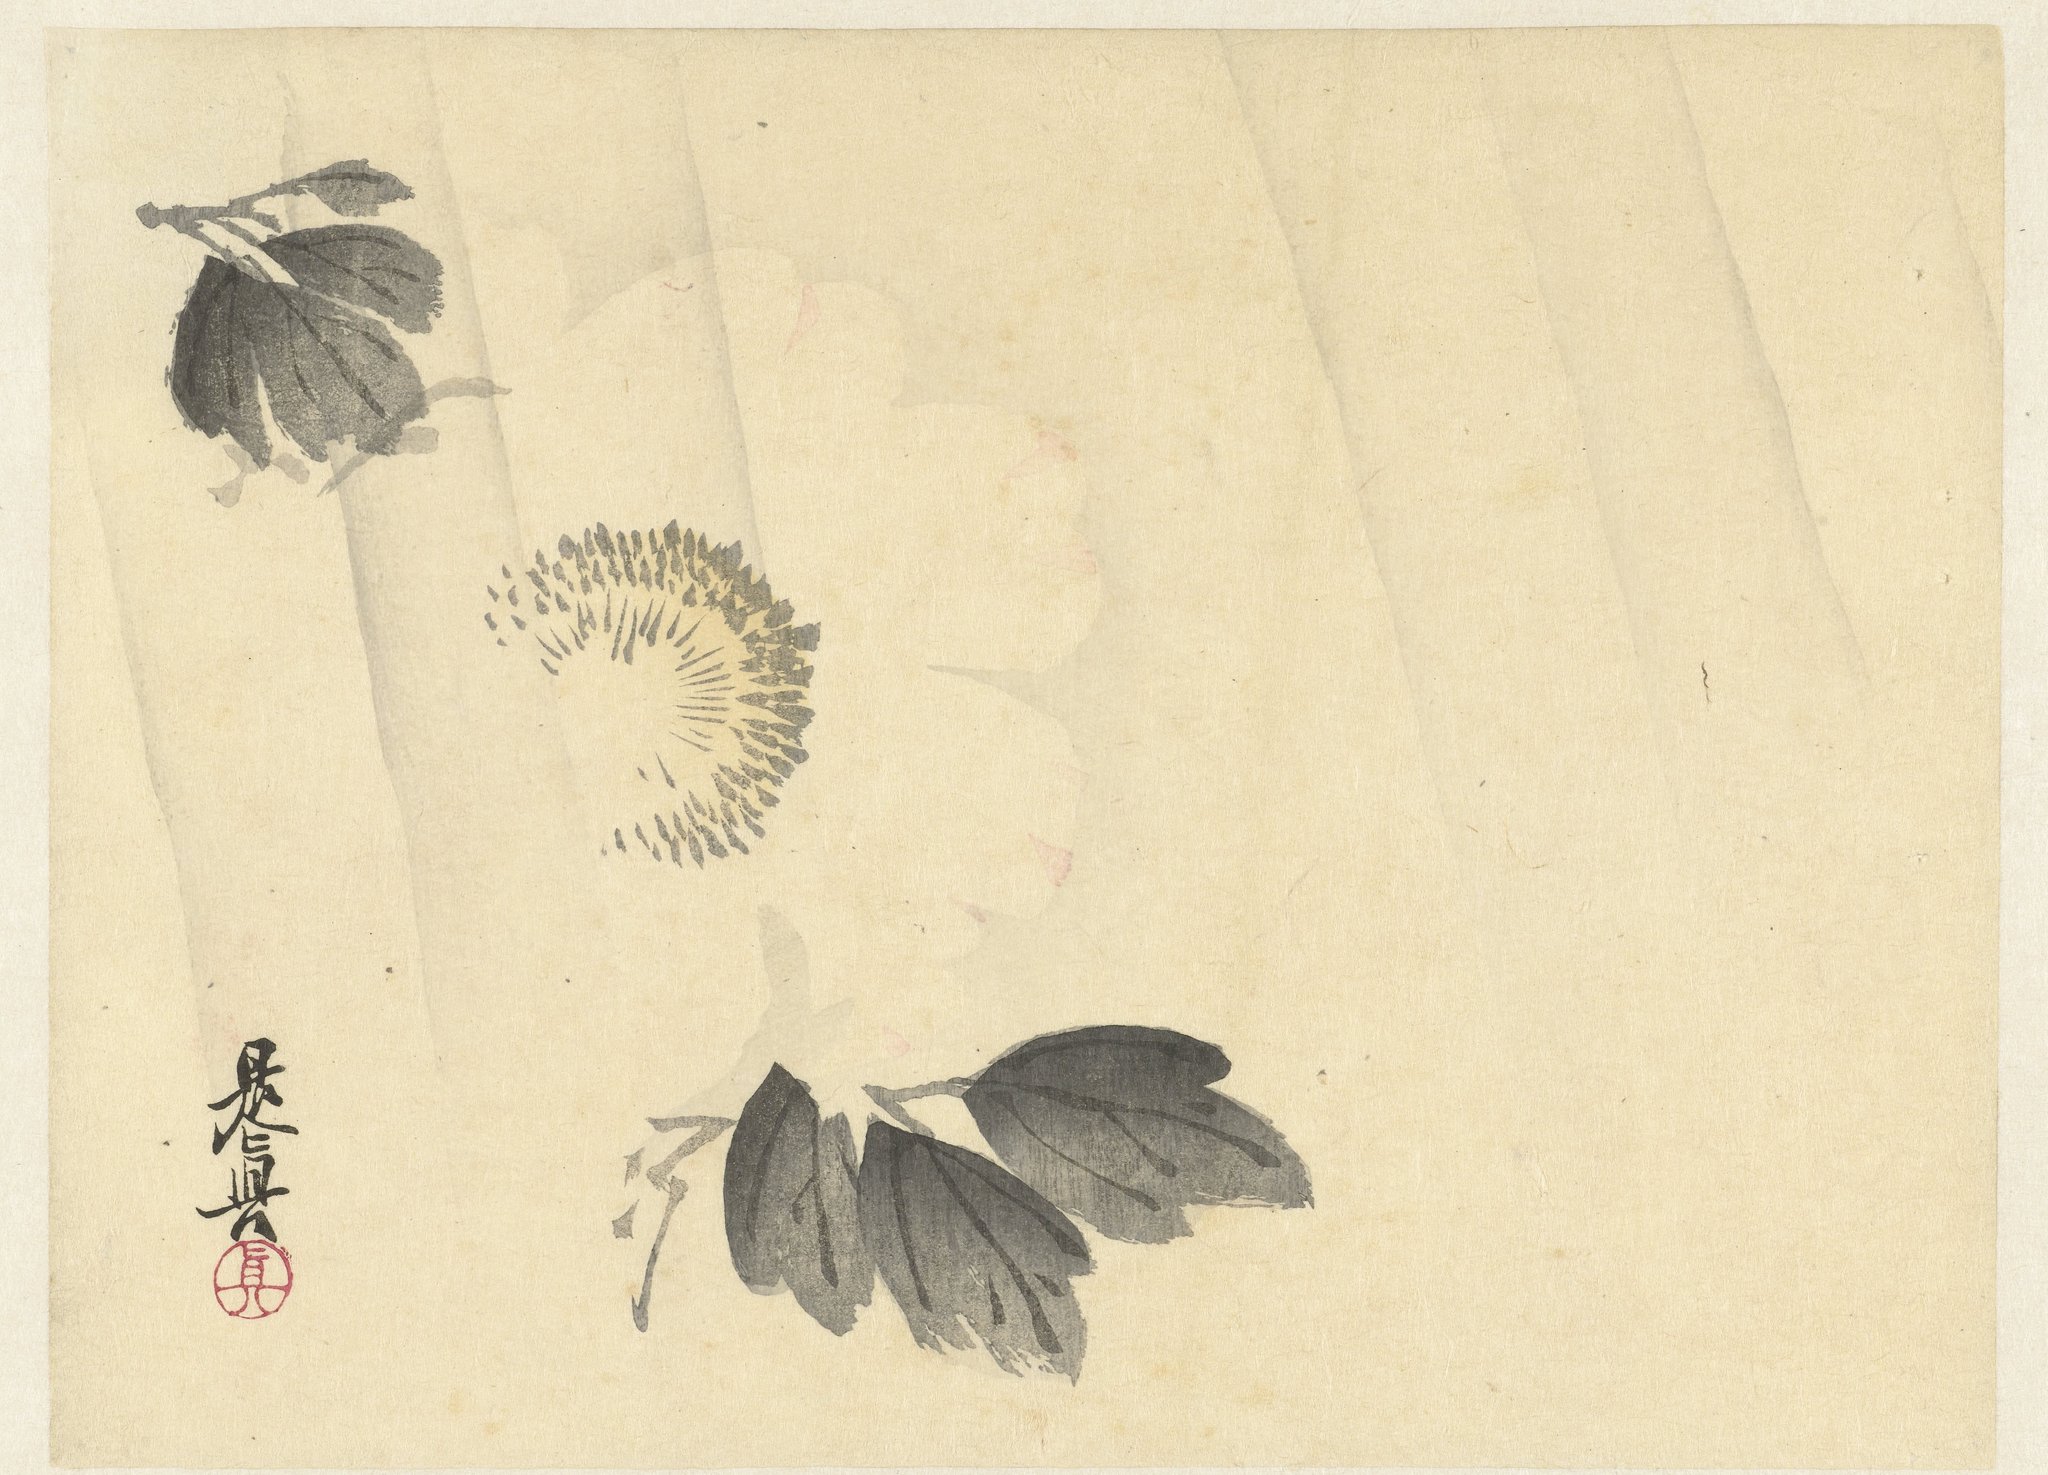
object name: print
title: Witte pioenroos in de regen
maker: shibata zeshin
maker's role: print maker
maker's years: 1807-1891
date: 1878-1882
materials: paper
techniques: blind stamped, woodcut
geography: japan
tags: flowers